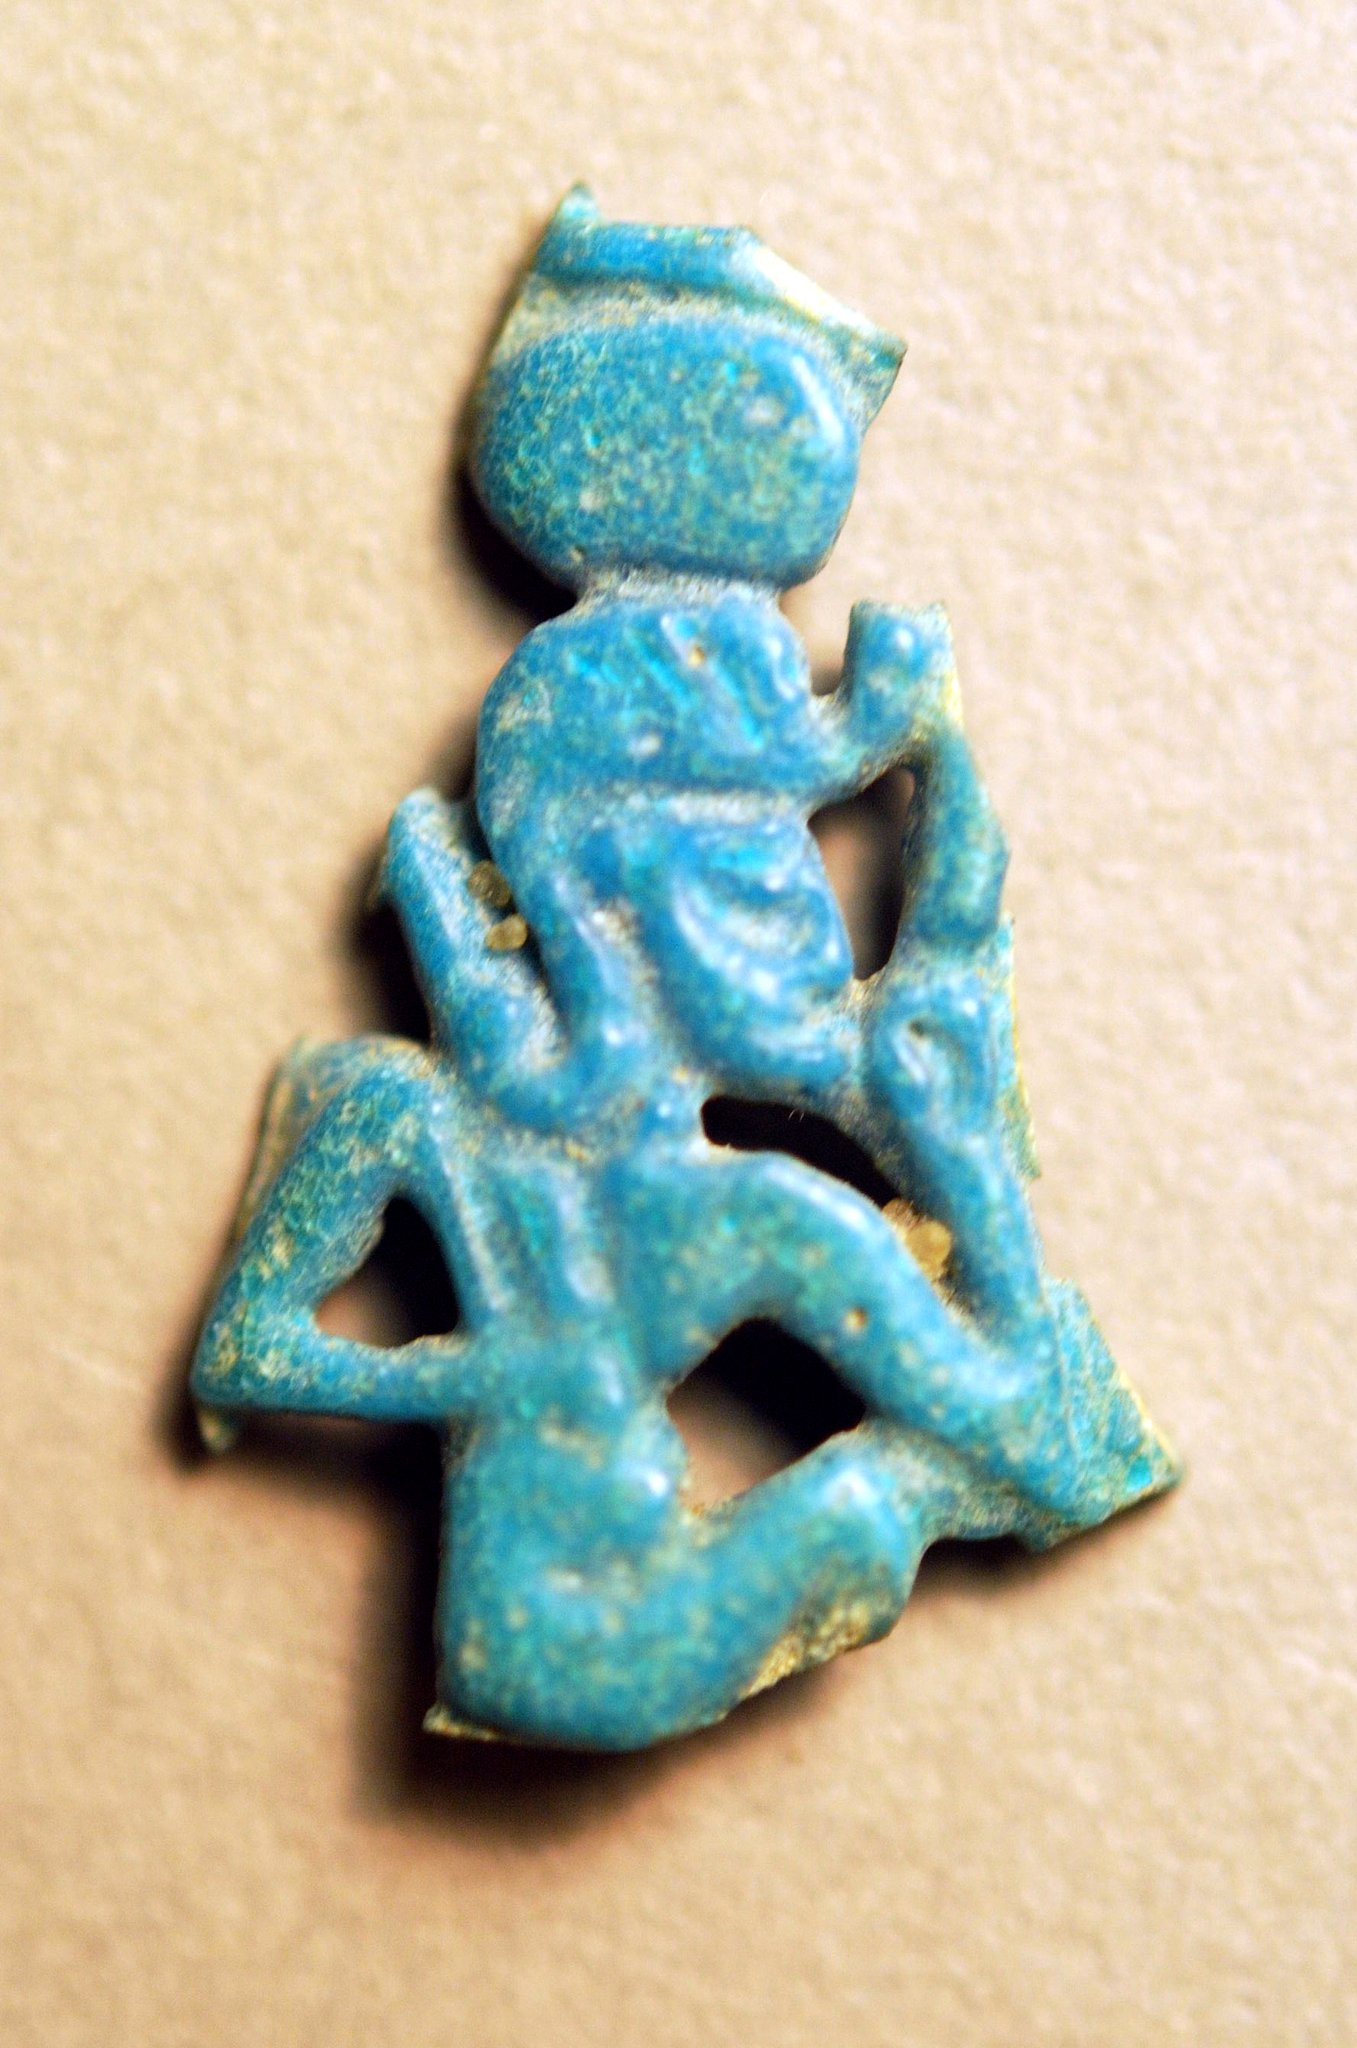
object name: amulet, son of horus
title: Fragmentary Amulet of Horus the Child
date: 1390-1352 BCE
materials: faience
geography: egypt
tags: horus